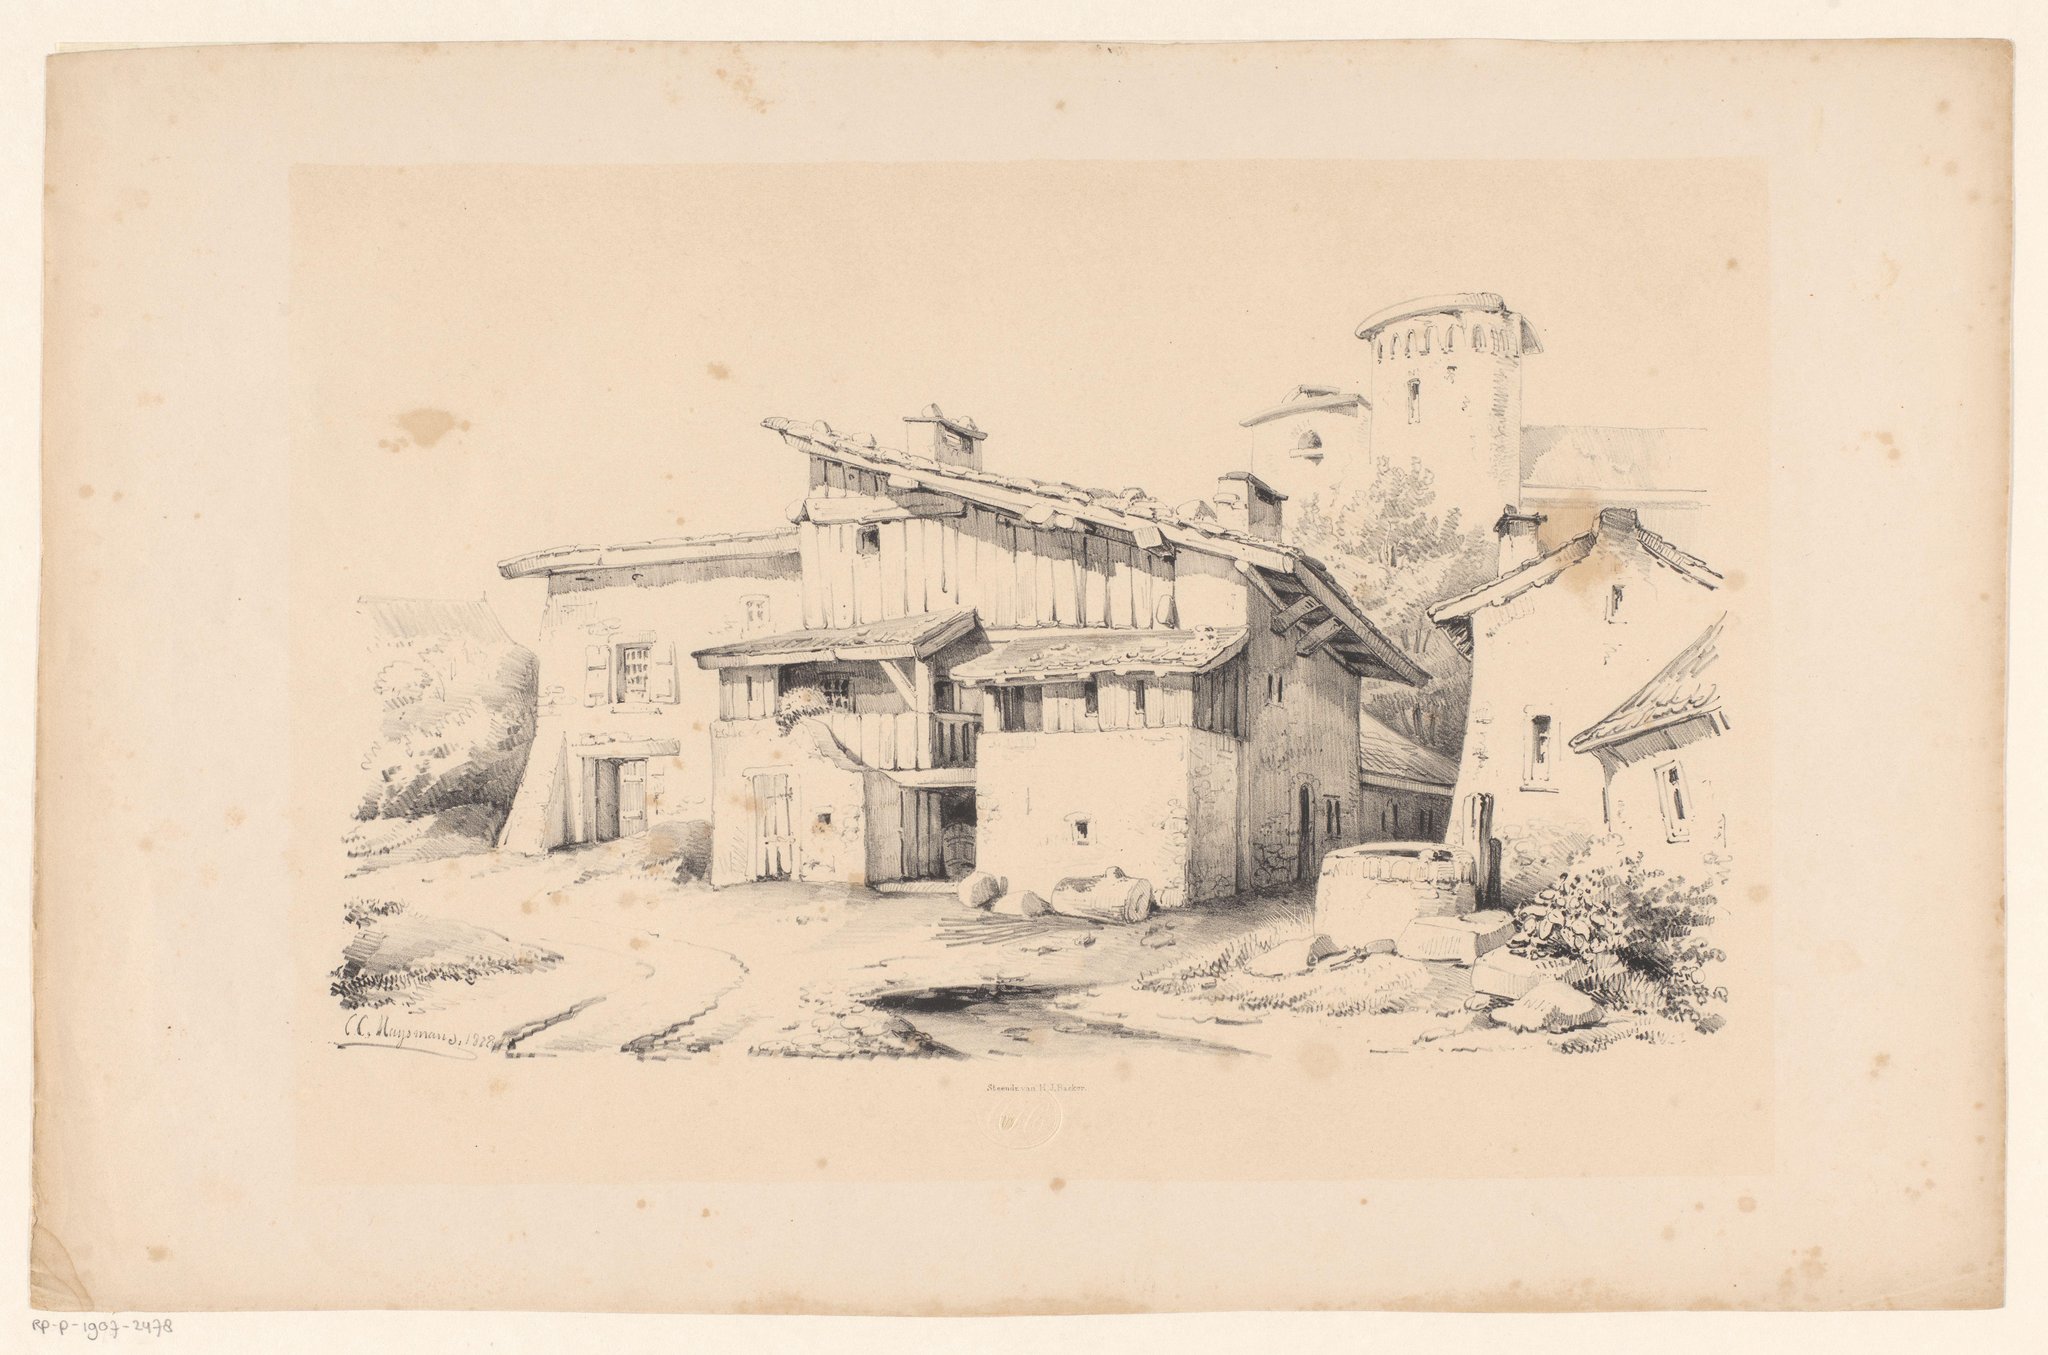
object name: print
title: Het Landschap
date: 1838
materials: paper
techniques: lithograph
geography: dordrecht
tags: rural housing, e.g. country-house, villa, cottage, civic architecture; edifices; dwellings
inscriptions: collector's mark: Lugt 2228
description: Deze prent maakt deel uit van een serie getiteld 'Het Landschap' door Constantinus Cornelis Huysmans. Deze serie werd door hem gebruikt als lesmateriaal op de Koninklijke Militaire Academie te Breda. Hij was docent handtekenen van 1837 tot 1866. Zie: W. van Giersbergen.